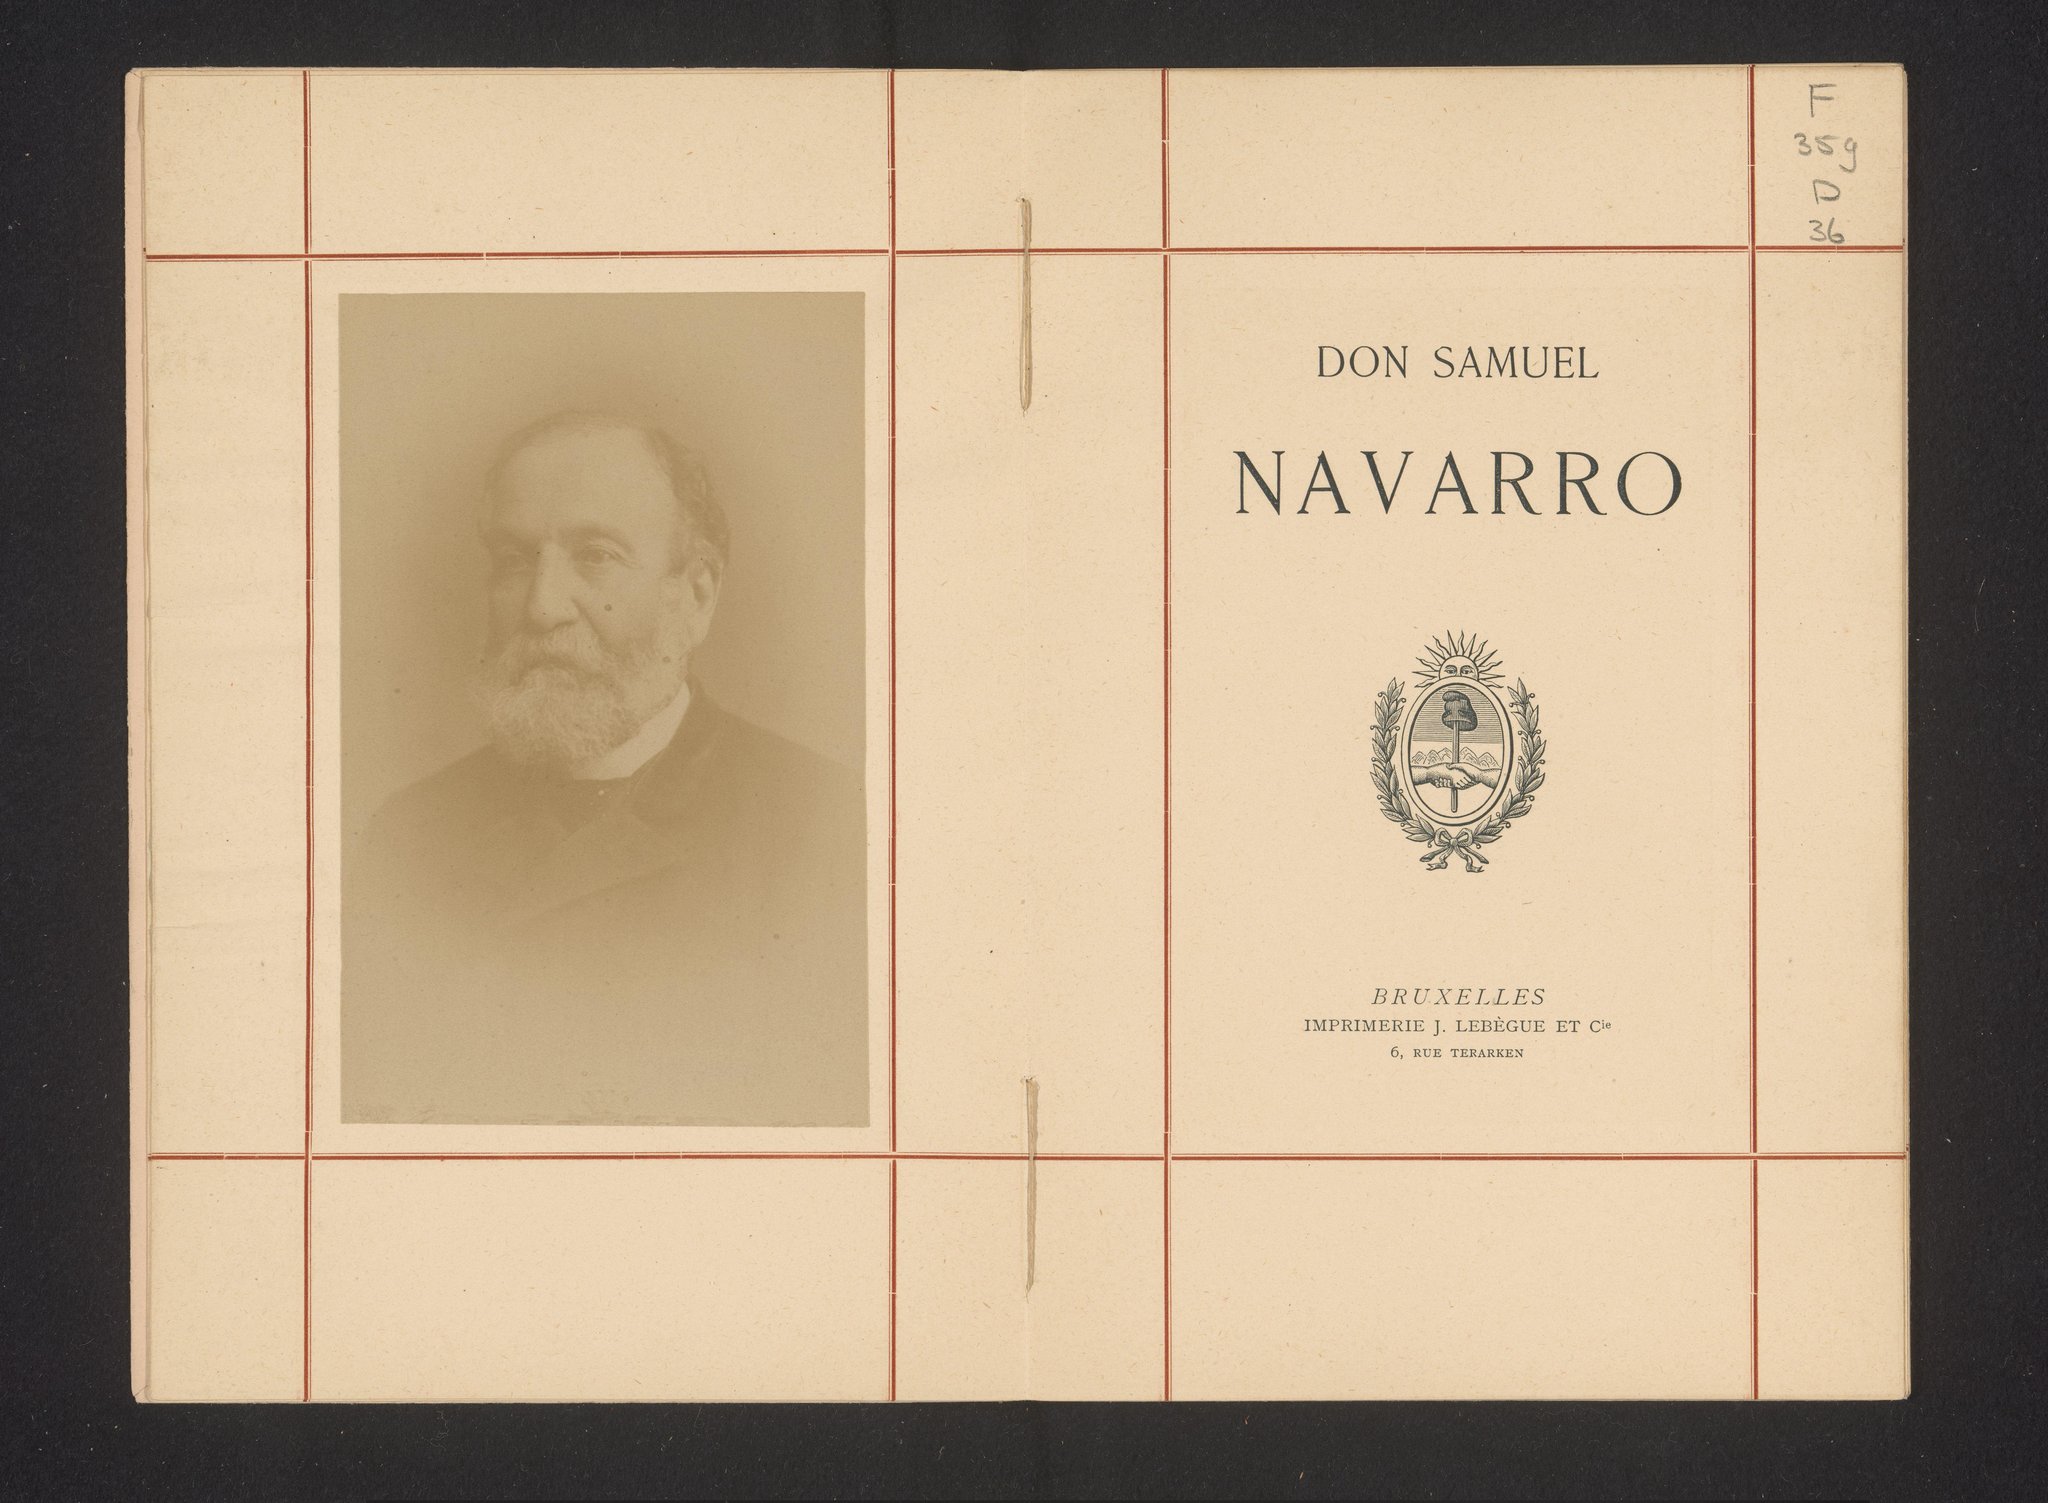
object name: photograph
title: Portret van een onbekende man, mogelijk Don Samuel Navarro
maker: Anonymous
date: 1883-1888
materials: photographic support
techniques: albumen print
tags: adult man, historical persons